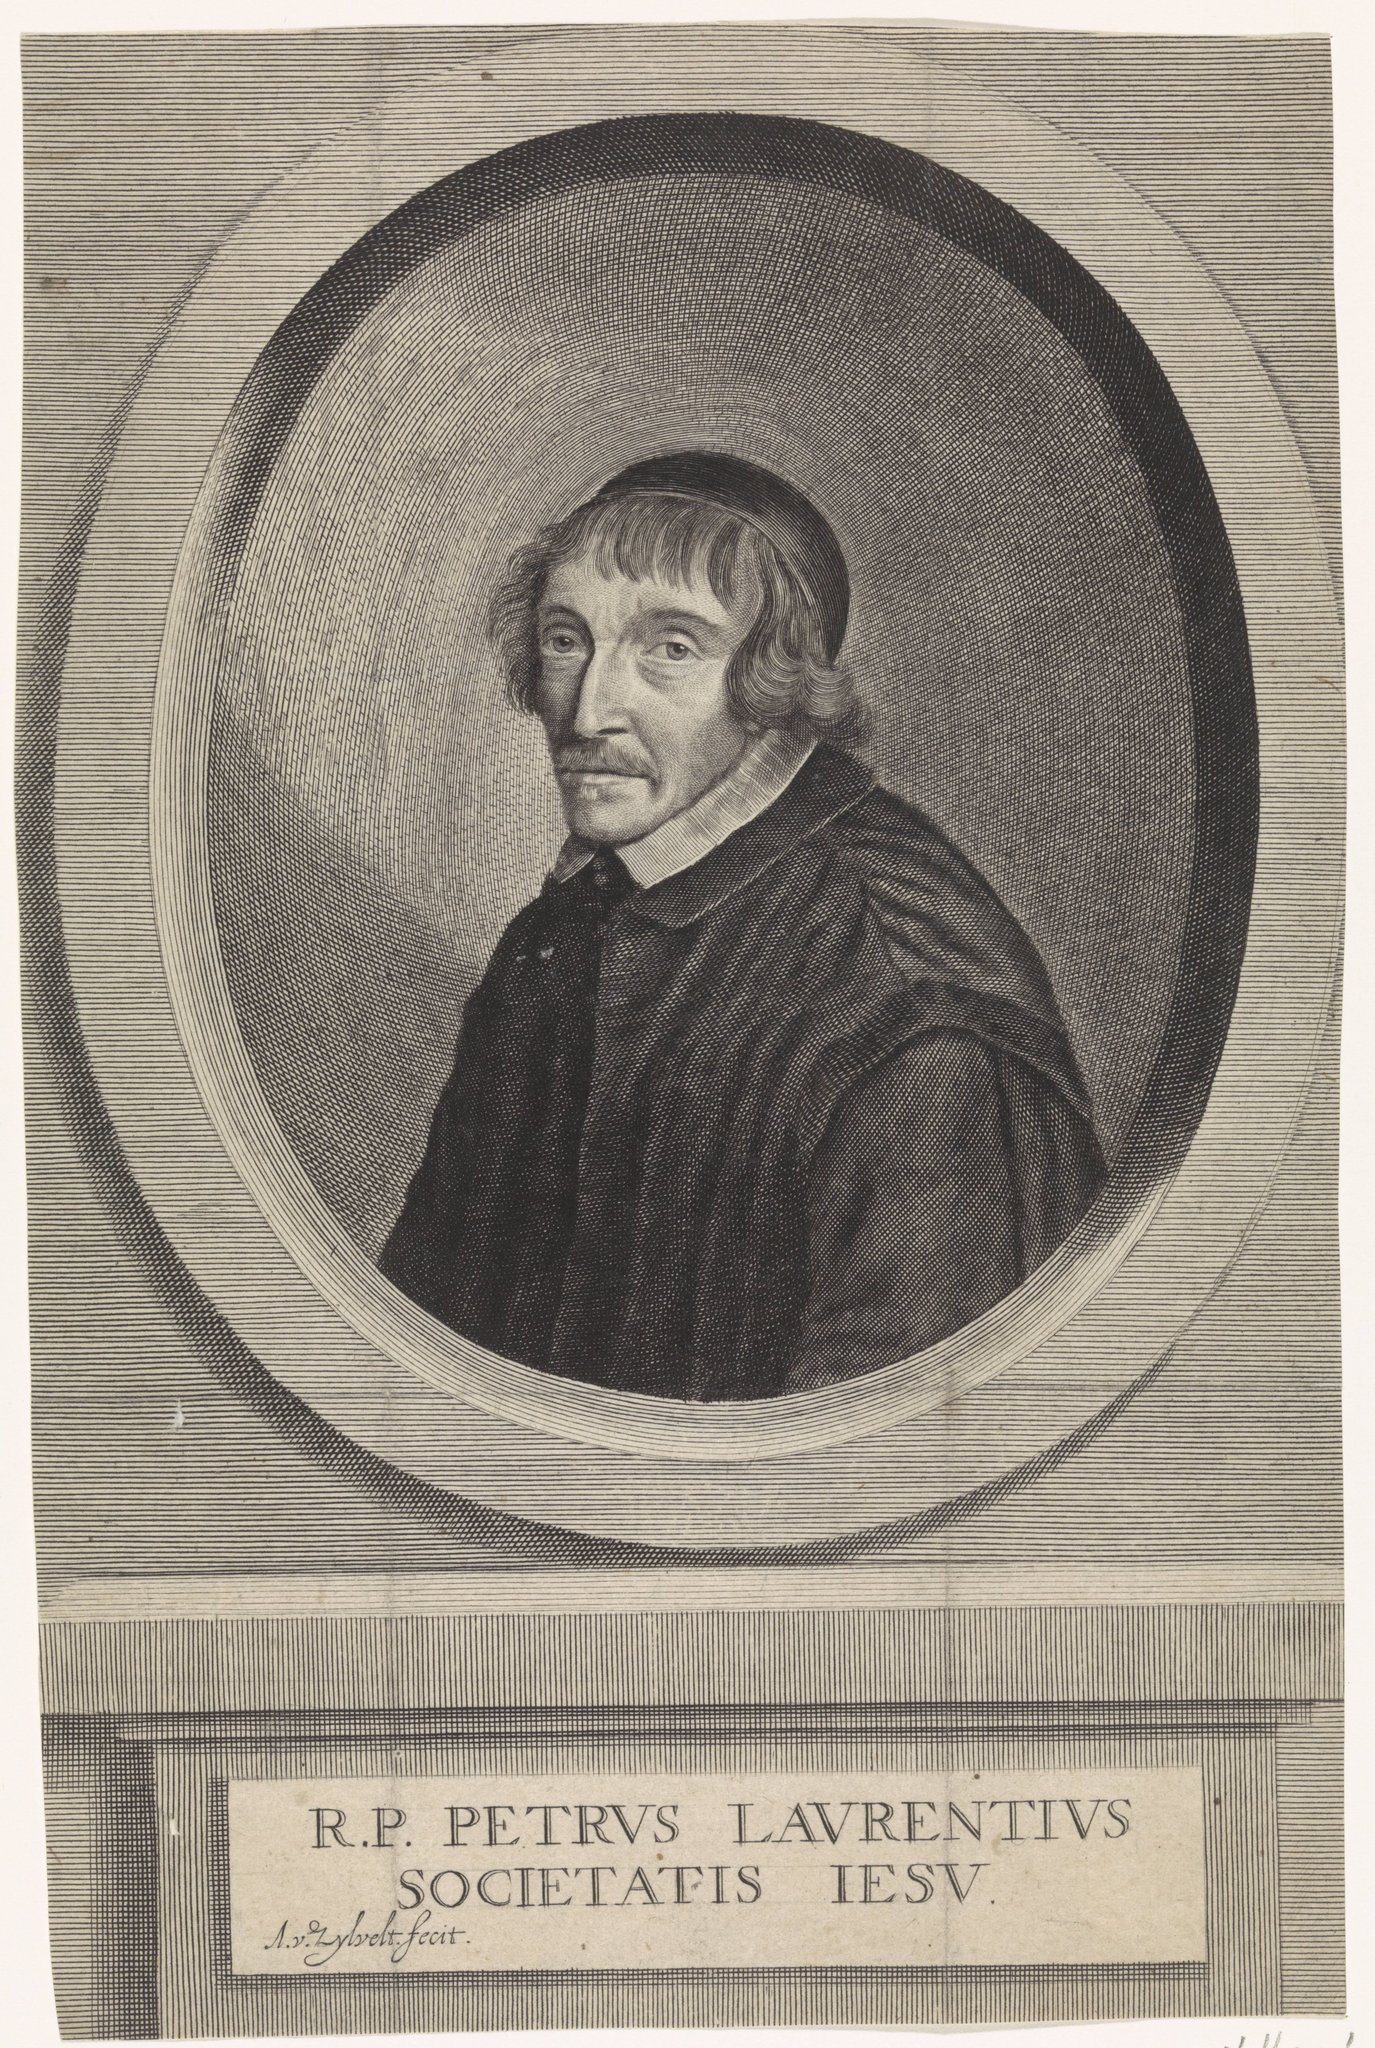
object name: print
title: Portret van Petrus Laurentius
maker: anthony van zijlvelt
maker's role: print maker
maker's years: 1637-1715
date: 1650-1695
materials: paper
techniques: engraving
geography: amsterdam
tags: mechelen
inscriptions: collector's mark: Lugt 2228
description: Portret van de jezuïet Petrus Luarentius uit Amsterdam.